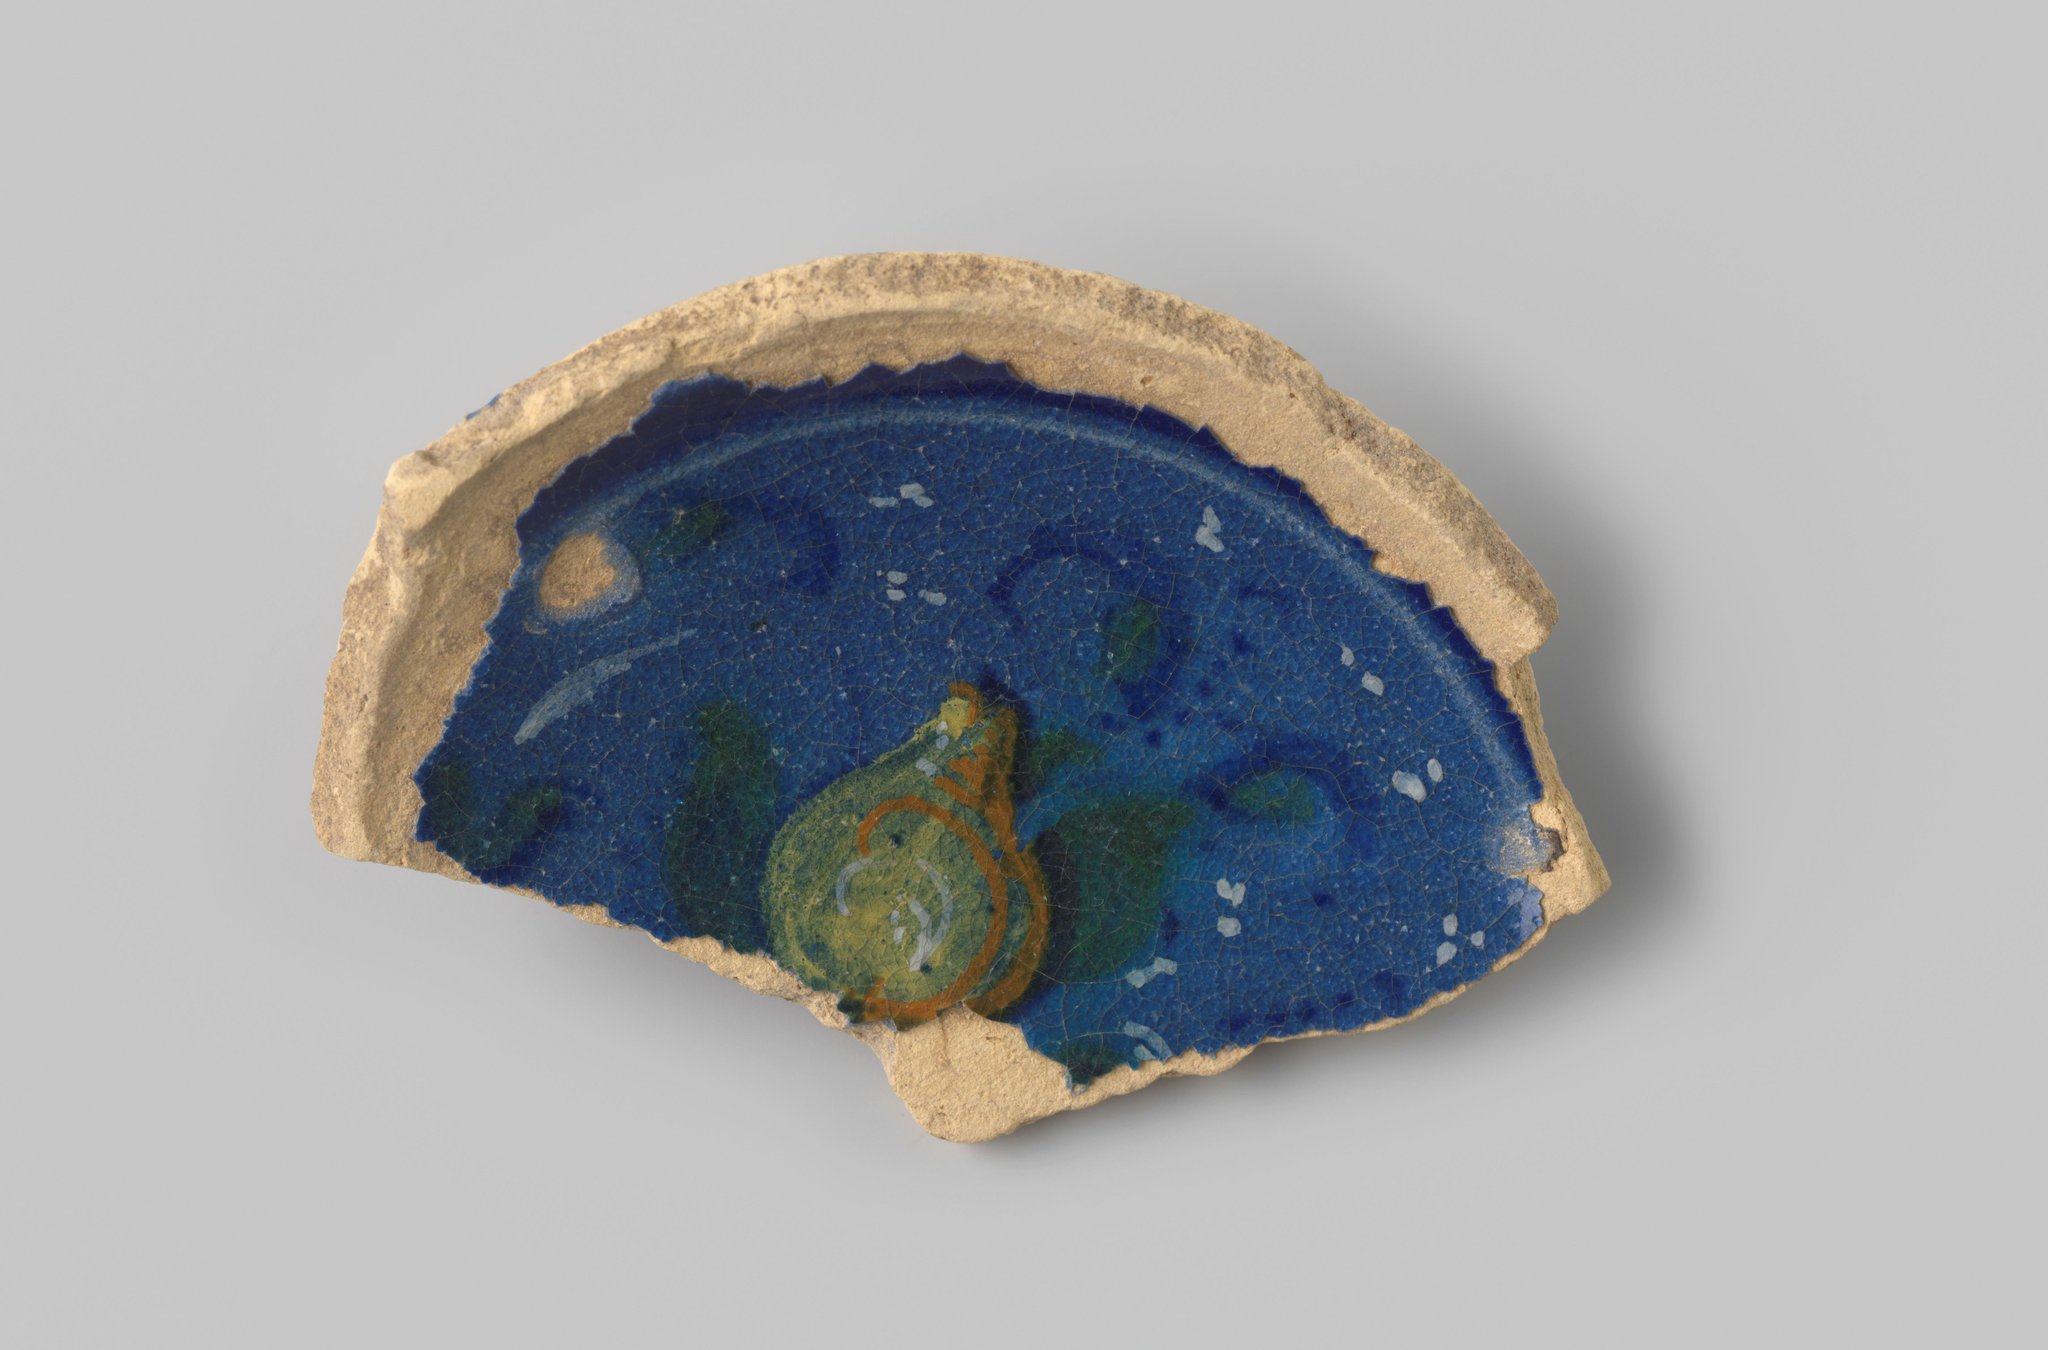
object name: sherd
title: Fragment van witbakkend aardewerk, aan de bovenzijde voorzien van blauw glazuur, met daarop een schildering van een peer in geel, oranje en groen glazuur, aan de onderzijde voorzien van blauw glazuur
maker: Anonymous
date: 1200-1899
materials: earthenware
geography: italy